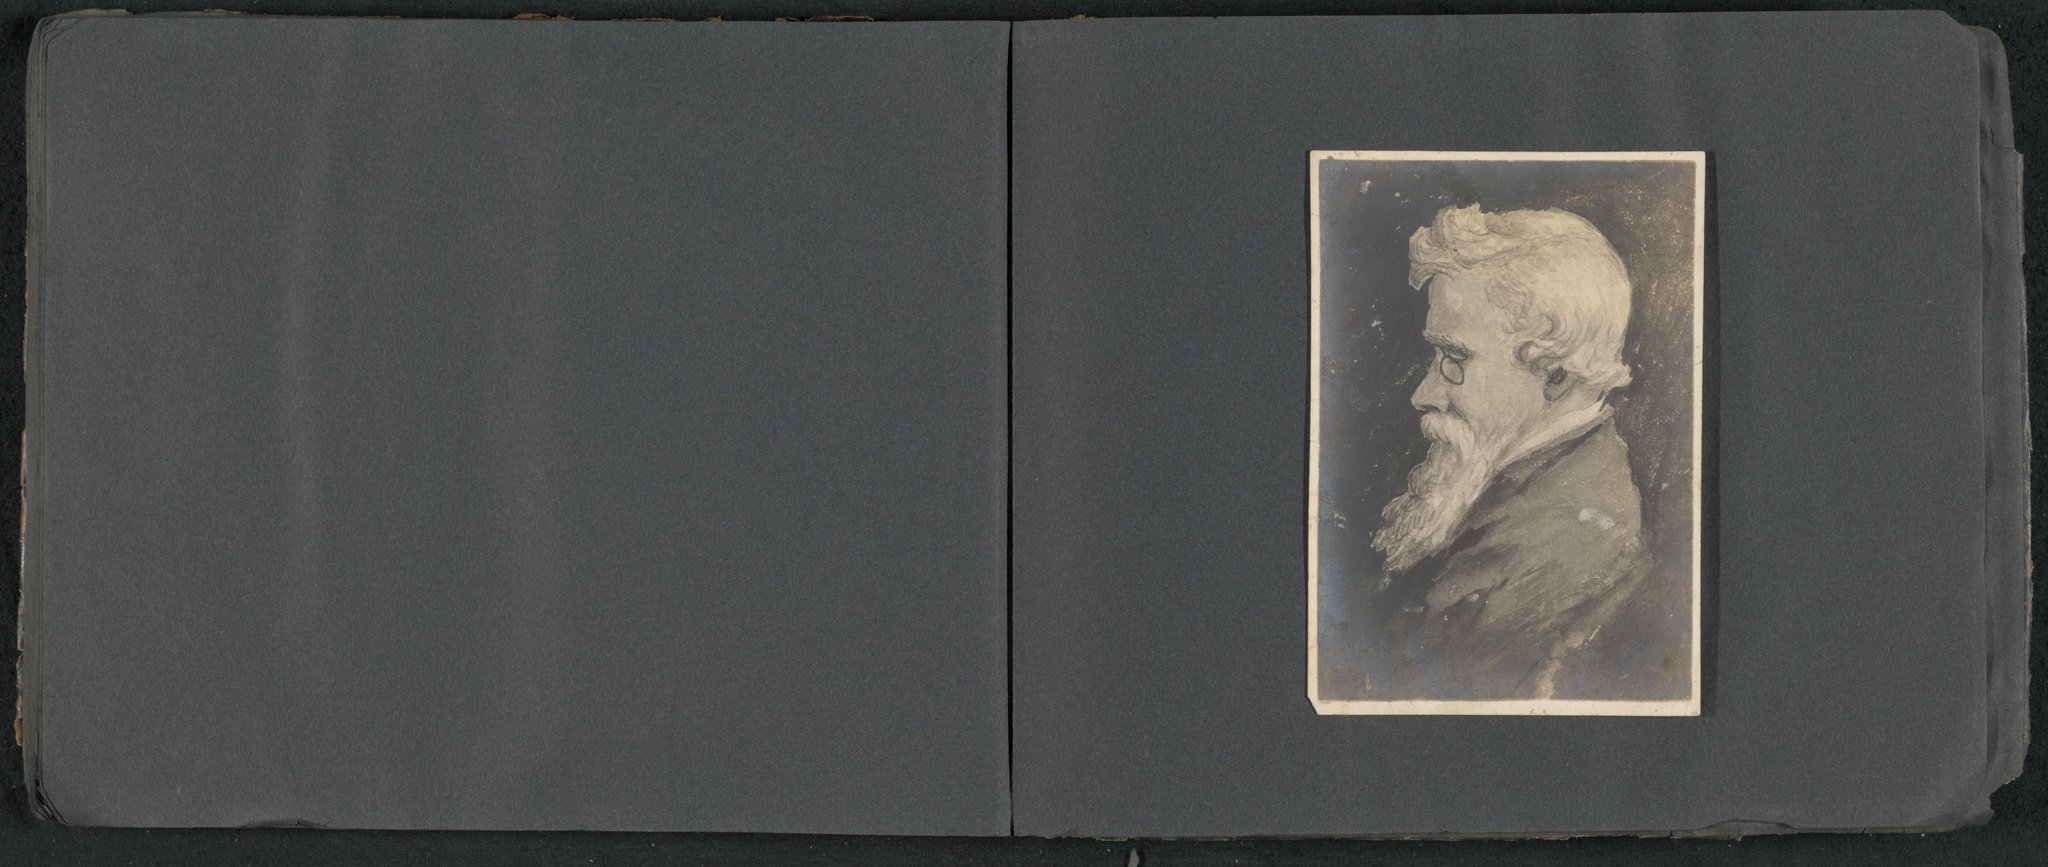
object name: reproduction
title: Fotoreproductie van (vermoedelijk) een tekening van een man met een baard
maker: Anonymous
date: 1890-1902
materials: photographic support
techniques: gelatin silver print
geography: united states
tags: adult man, historical persons, beard, united states of america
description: Onderdeel van Familiealbum met voornamelijk foto's van een jong Amerikaans meisje.